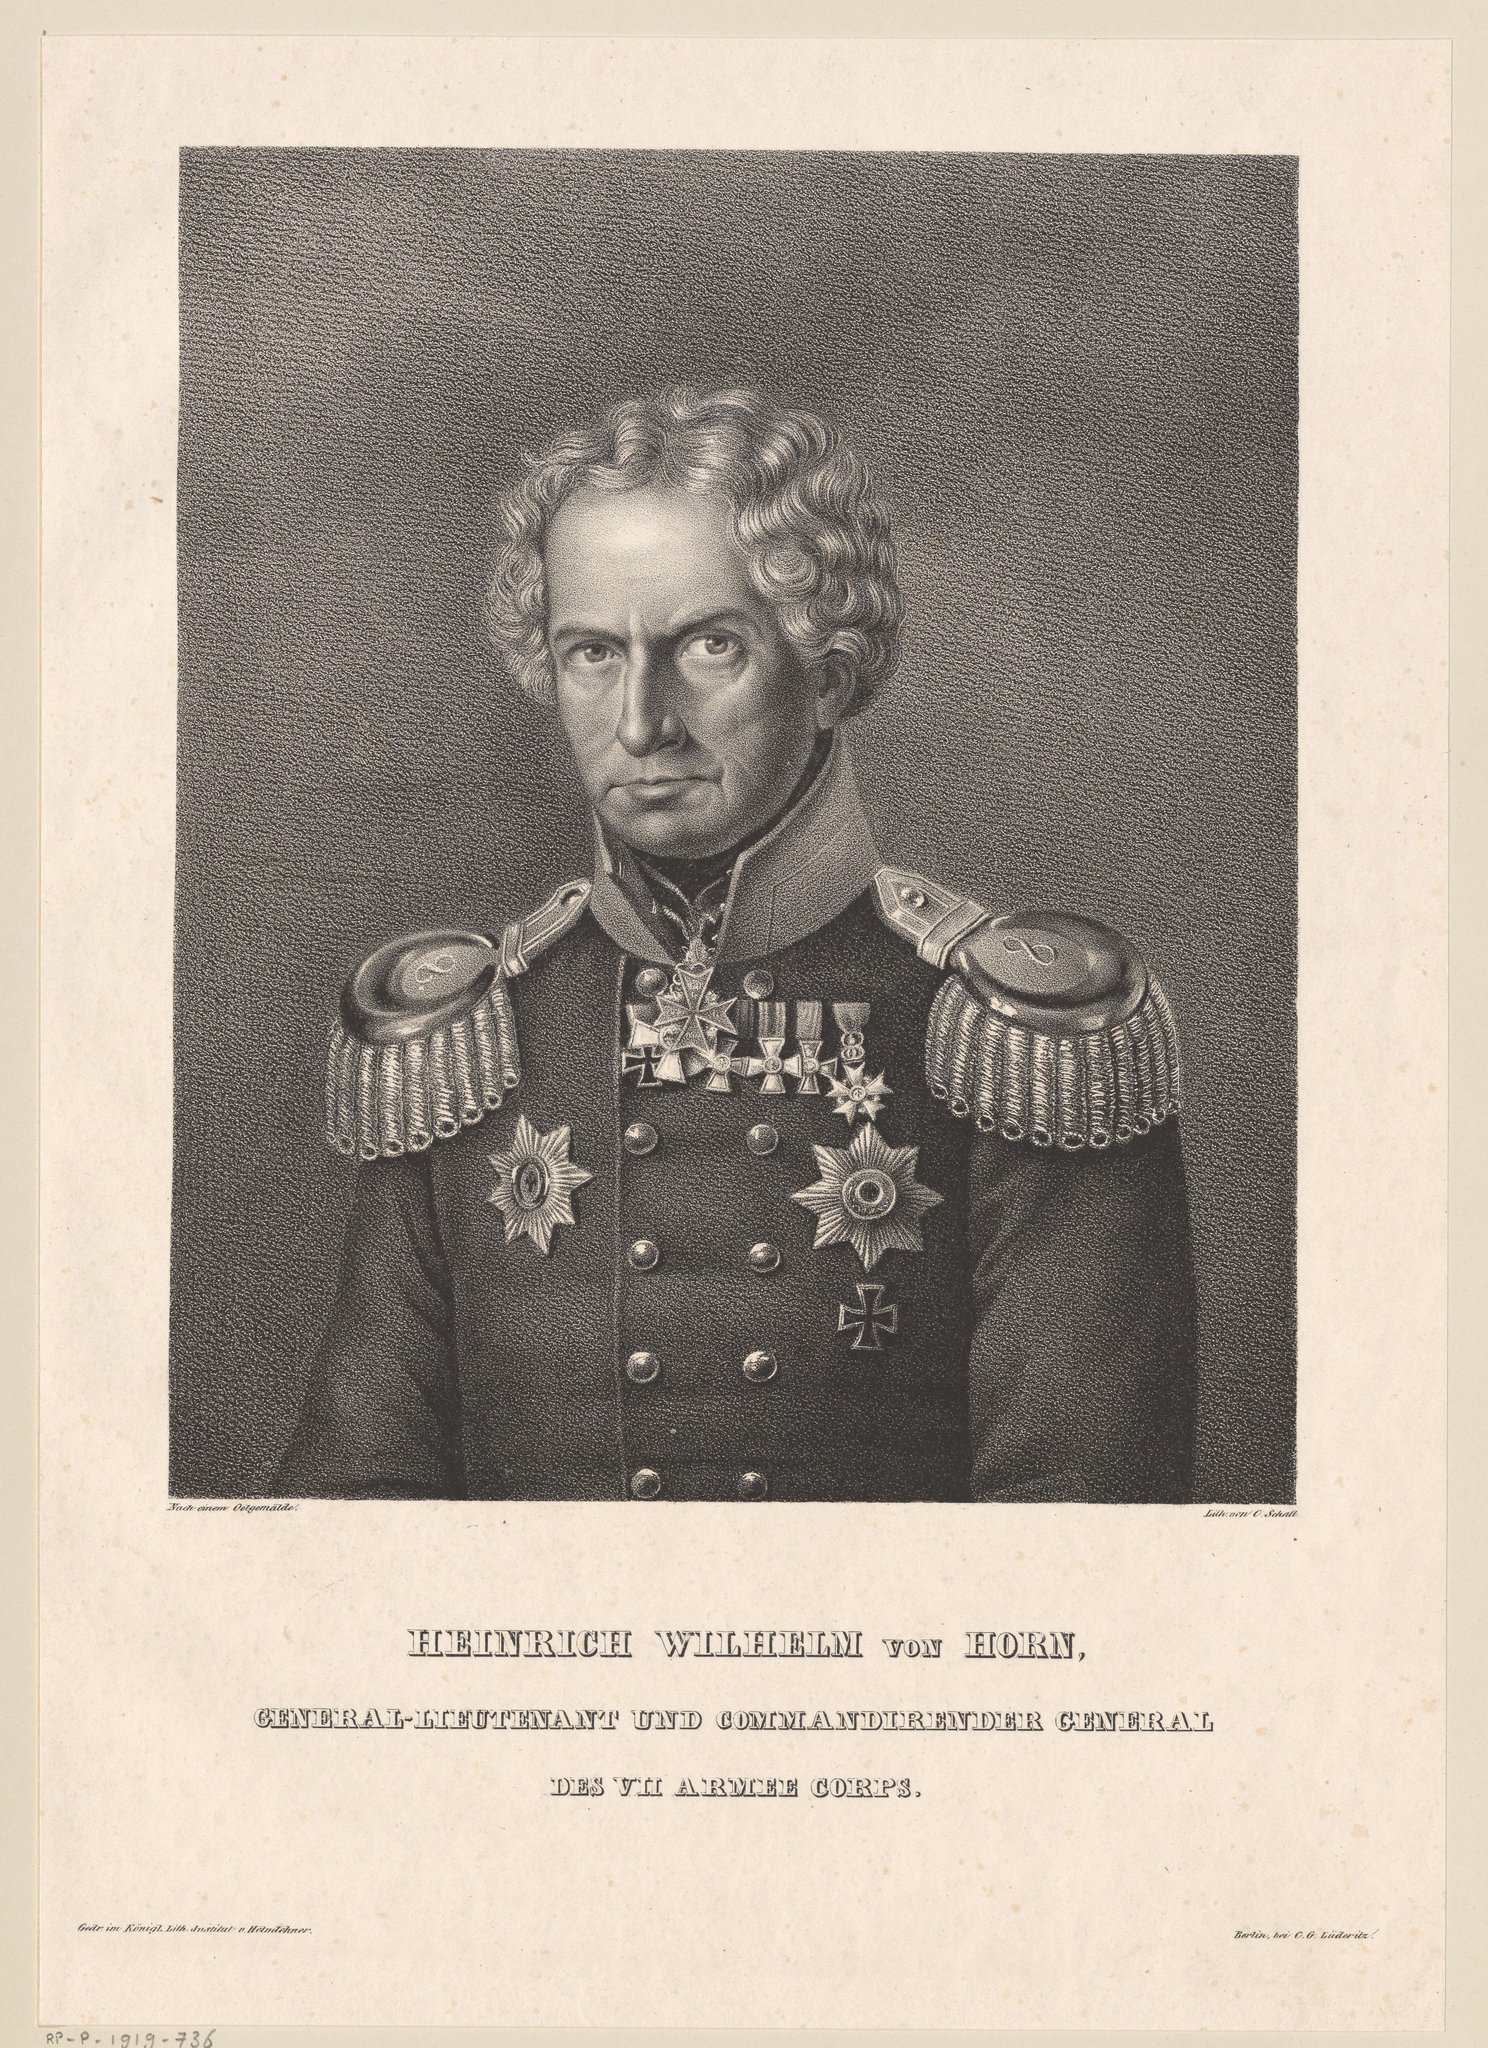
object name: print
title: Portret van Heinrich Wilhelm von Horn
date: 1828-1860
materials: paper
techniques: lithograph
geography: berlin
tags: commander-in-chief, general, marshal, historical persons, medals and other marks of military honour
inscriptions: collector's mark: Lugt 2228